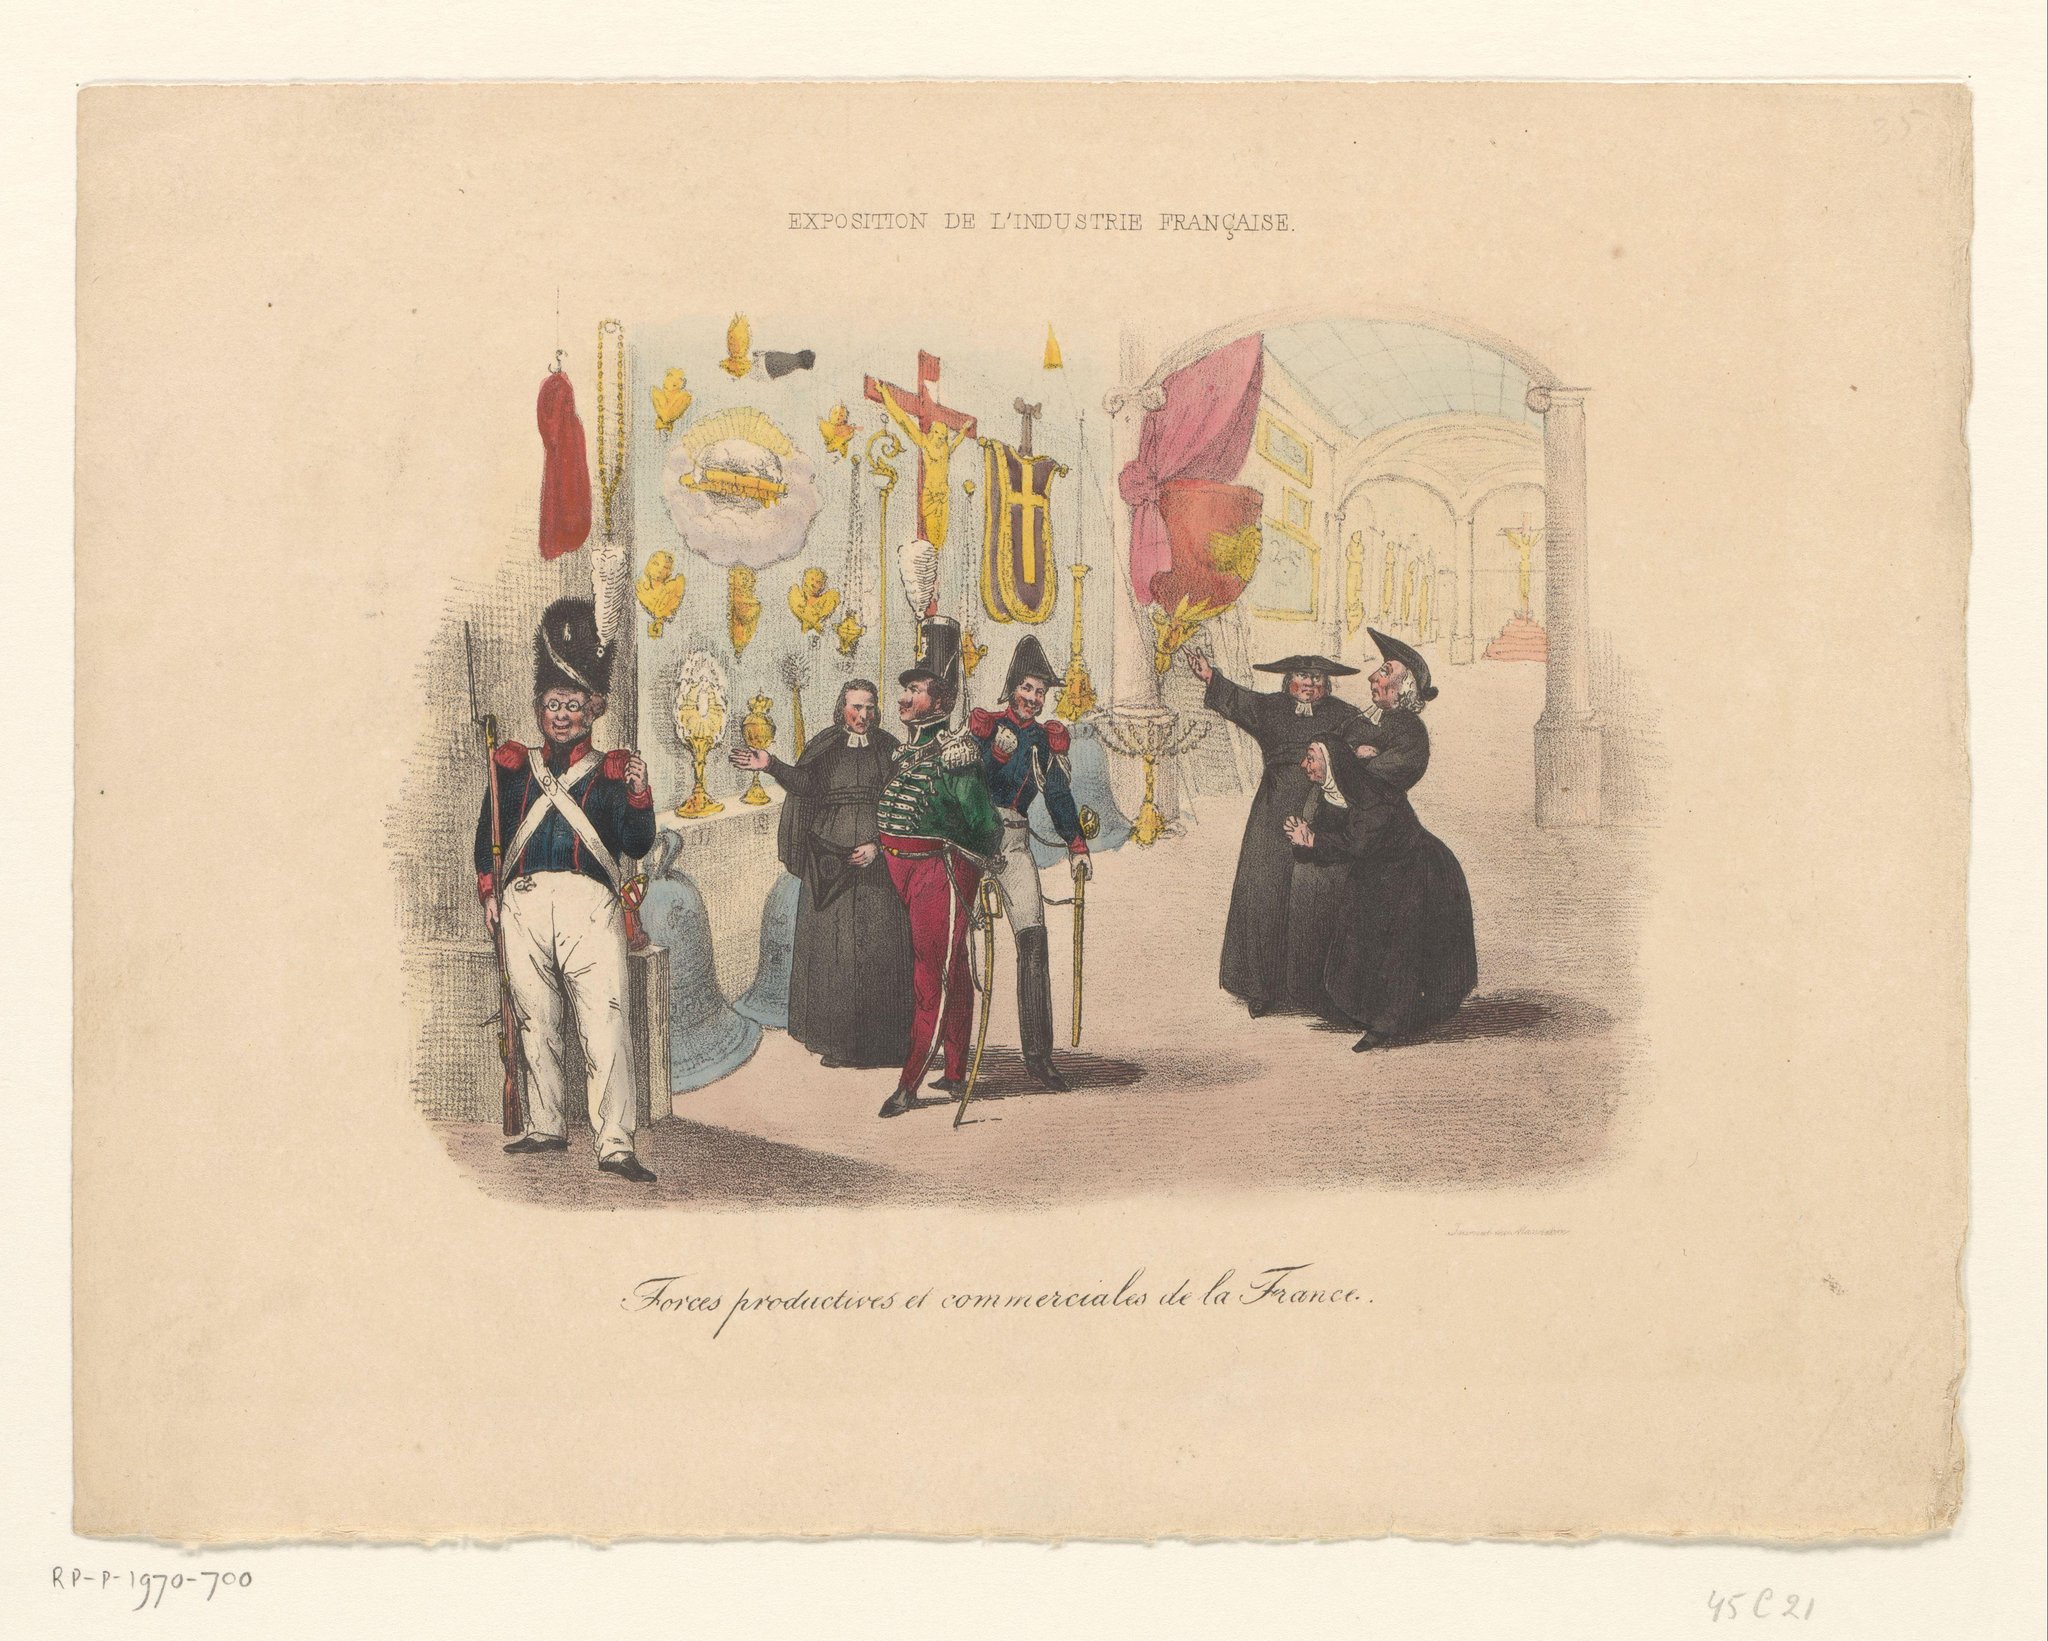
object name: cartoon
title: Spotprent op de productie van kerkelijke objecten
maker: Anonymous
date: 1798-1849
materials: paper, watercolor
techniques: hand coloring, lithograph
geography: france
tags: (liturgical) equipment of church, (military) uniforms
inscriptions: collector's mark: Lugt 2228, collector's mark: ‘L. A. DE VRIES’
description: Spotprent op de productie in Frankrijk van kerkelijke objecten. Een aantal militairen en geestelijken bewondert een uitstalling van katholieke kerkelijke objecten aan de muur.